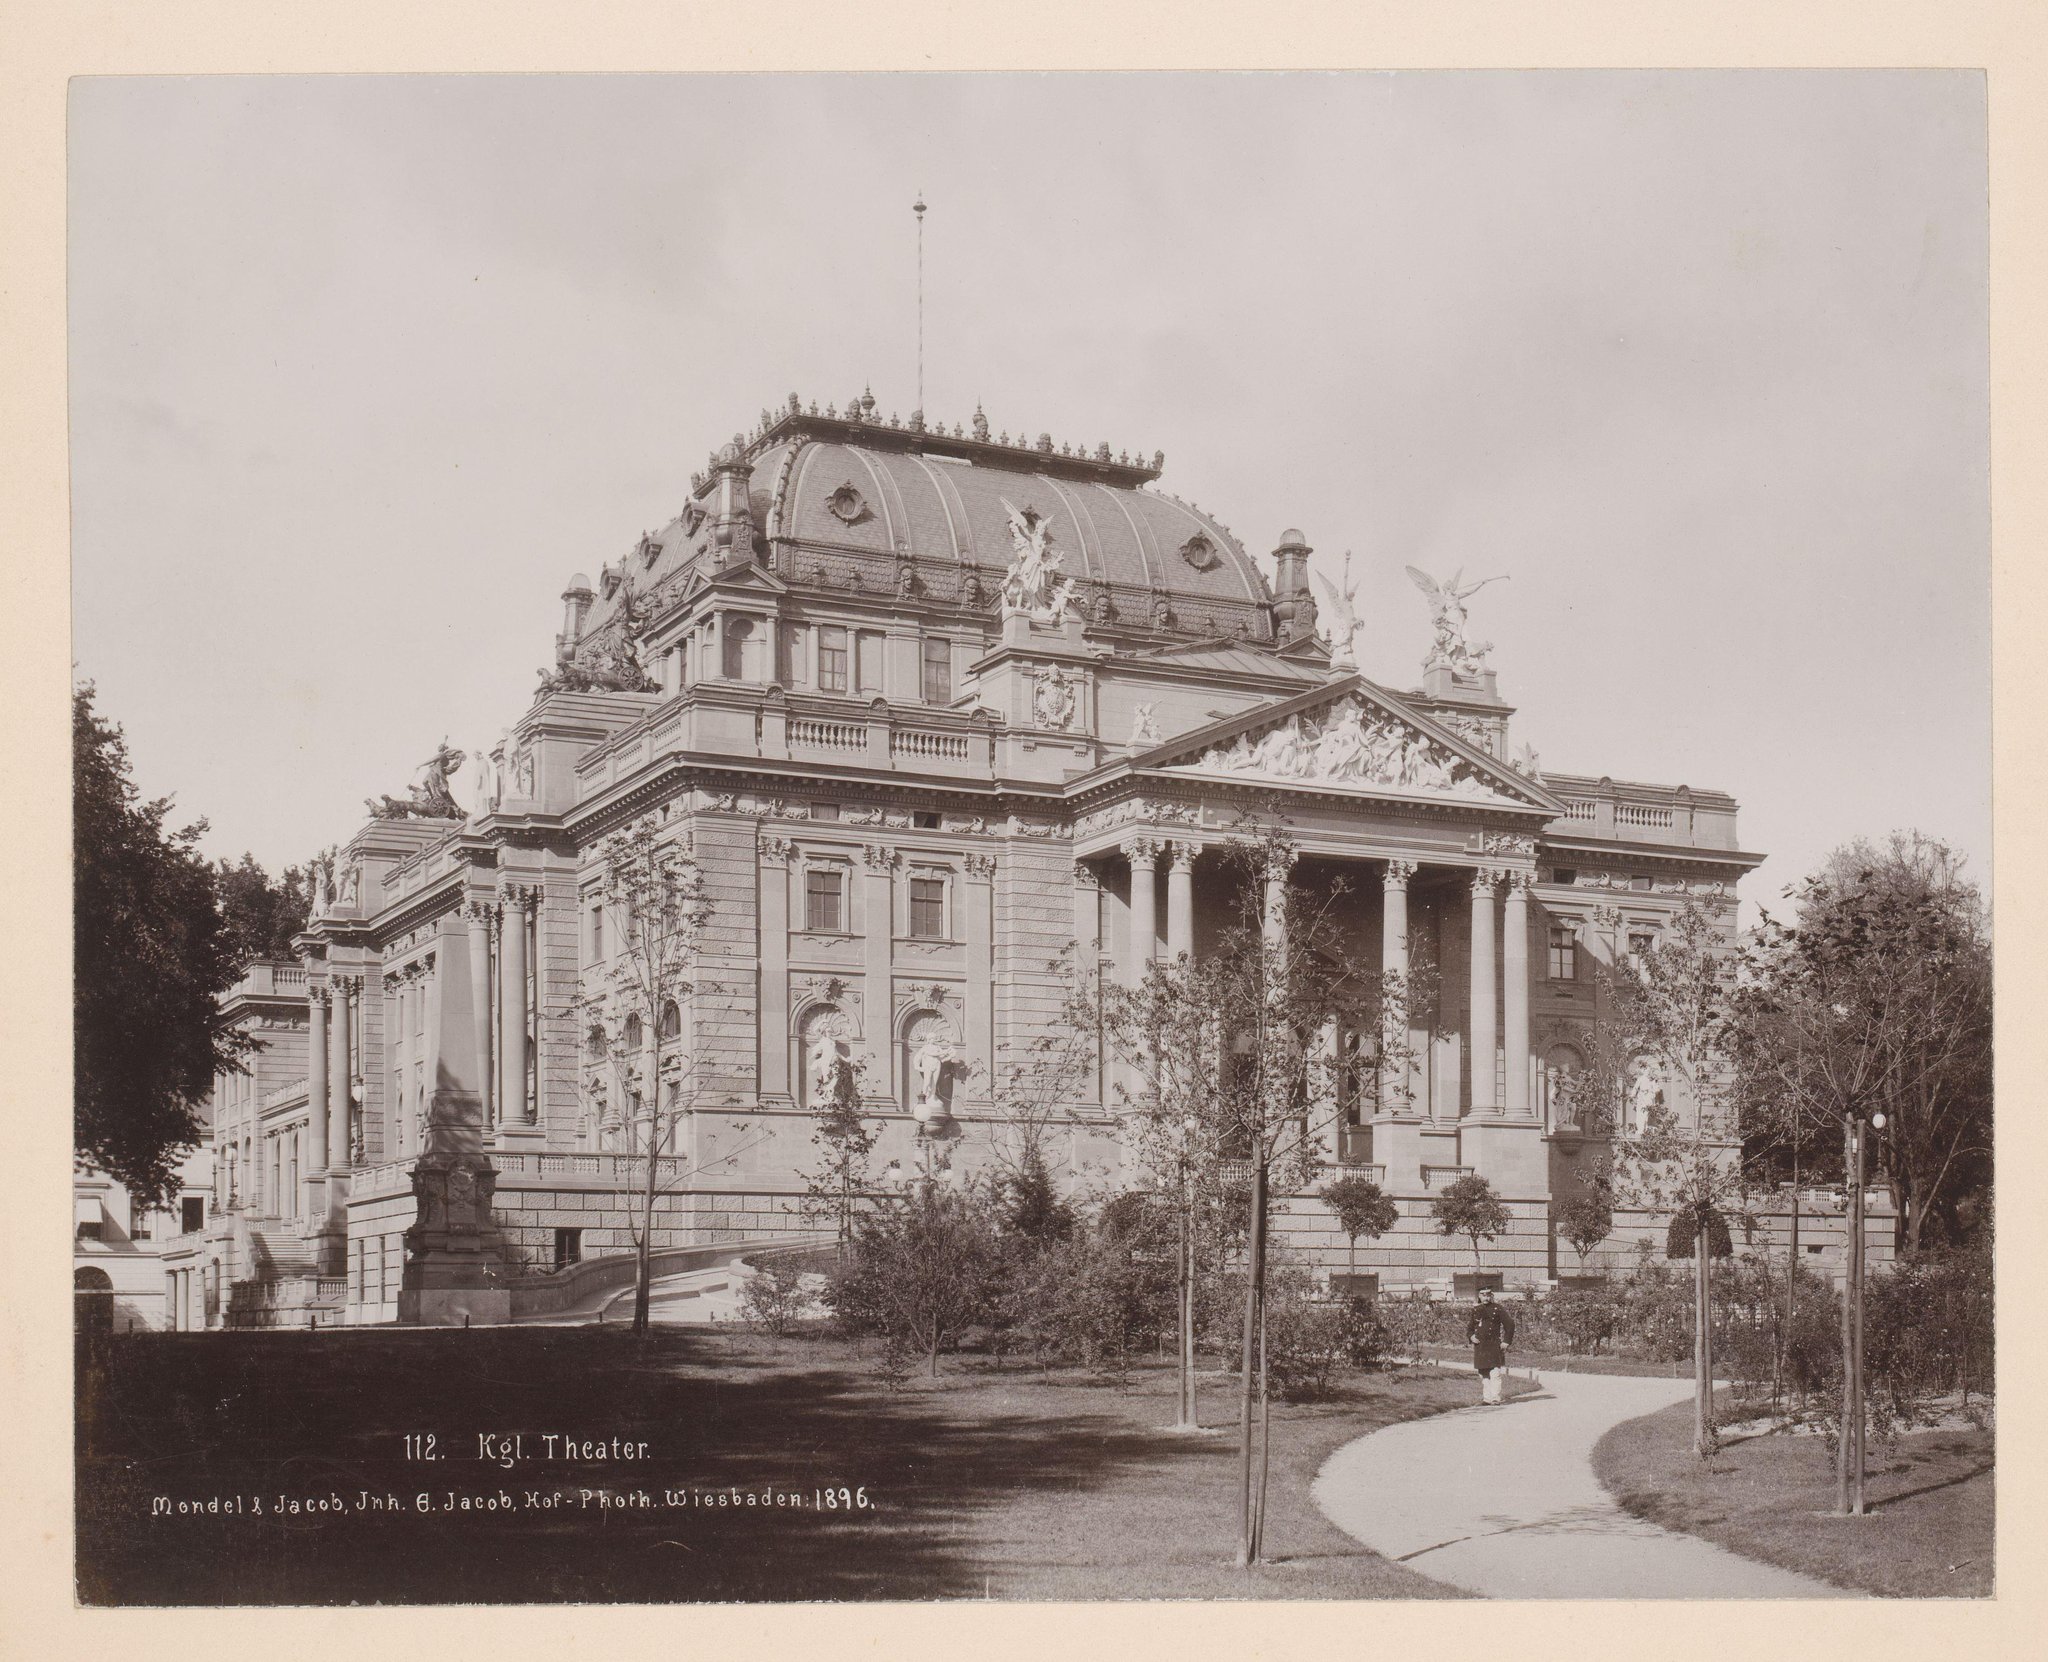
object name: photograph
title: Königliches Theater, Wiesbaden, Duitsland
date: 1896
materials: cardboard, paper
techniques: collodion silver print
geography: wiesbaden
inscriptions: inscription: ‘112. Kgl. Theater. // Mondel & Jacob, Inh. G. Jacob, Hof-Photh. Wiesbaden: 1896.’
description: Aanzicht op het Königliche Theater, met een park, en een man in uniform op de voorgrond, Wiesbaden, Duitsland.